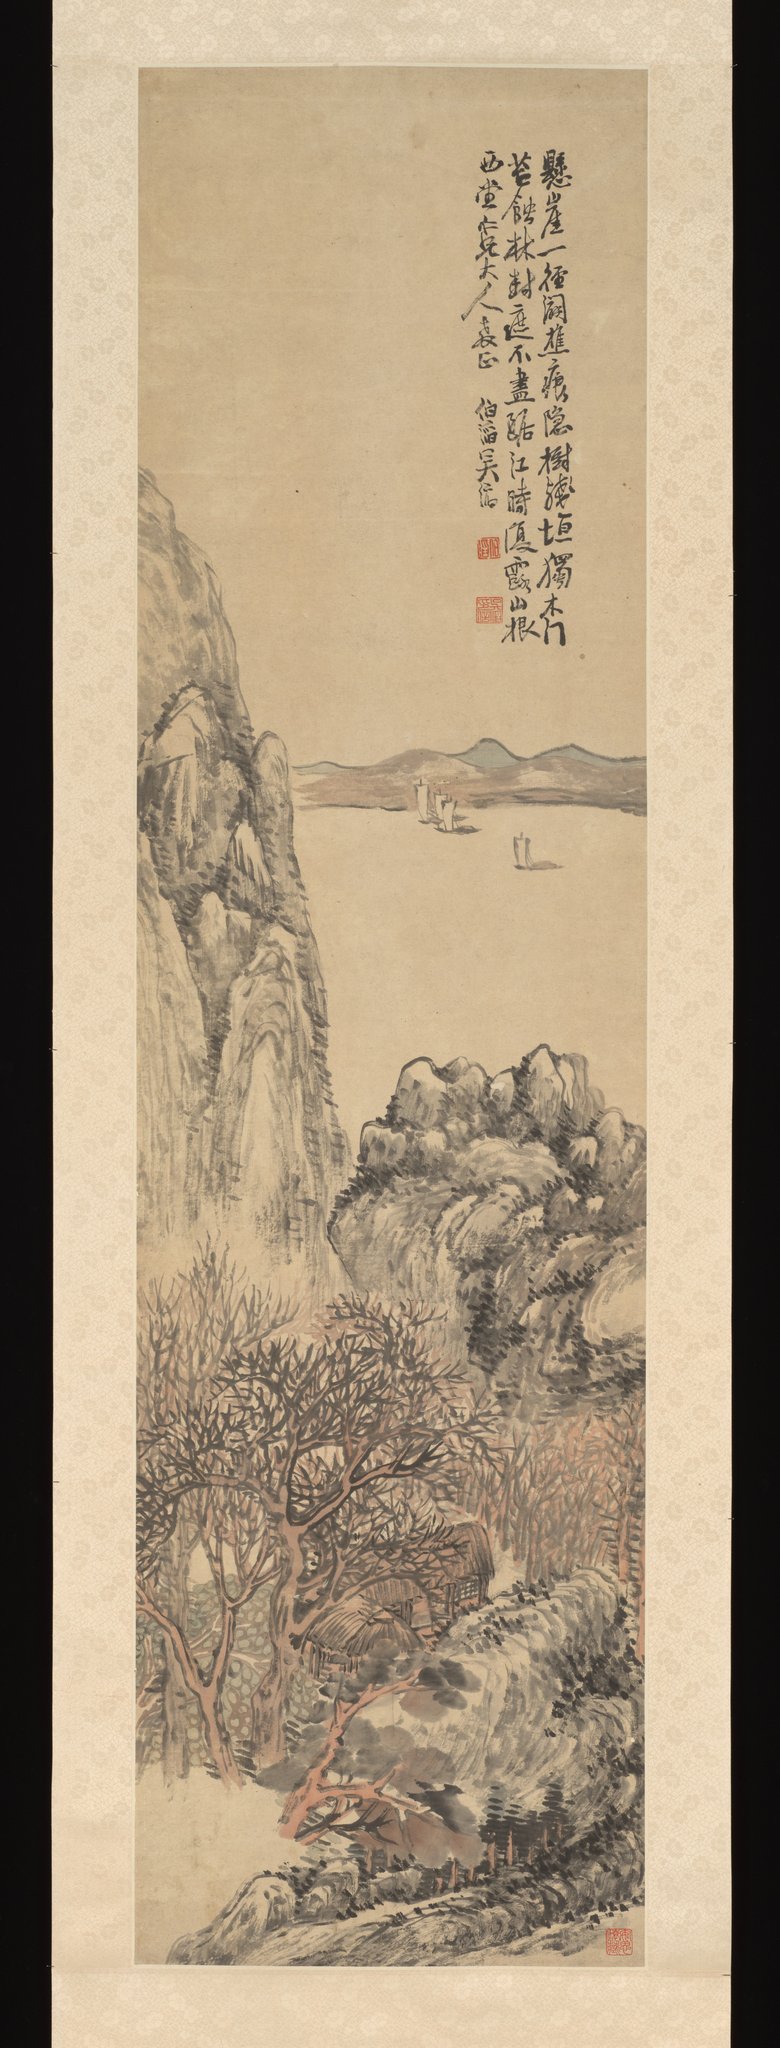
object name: hanging scroll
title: Landscape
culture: chinese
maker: wu tao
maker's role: artist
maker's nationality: chinese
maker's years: 1840-1895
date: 1840-1895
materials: ink, paper